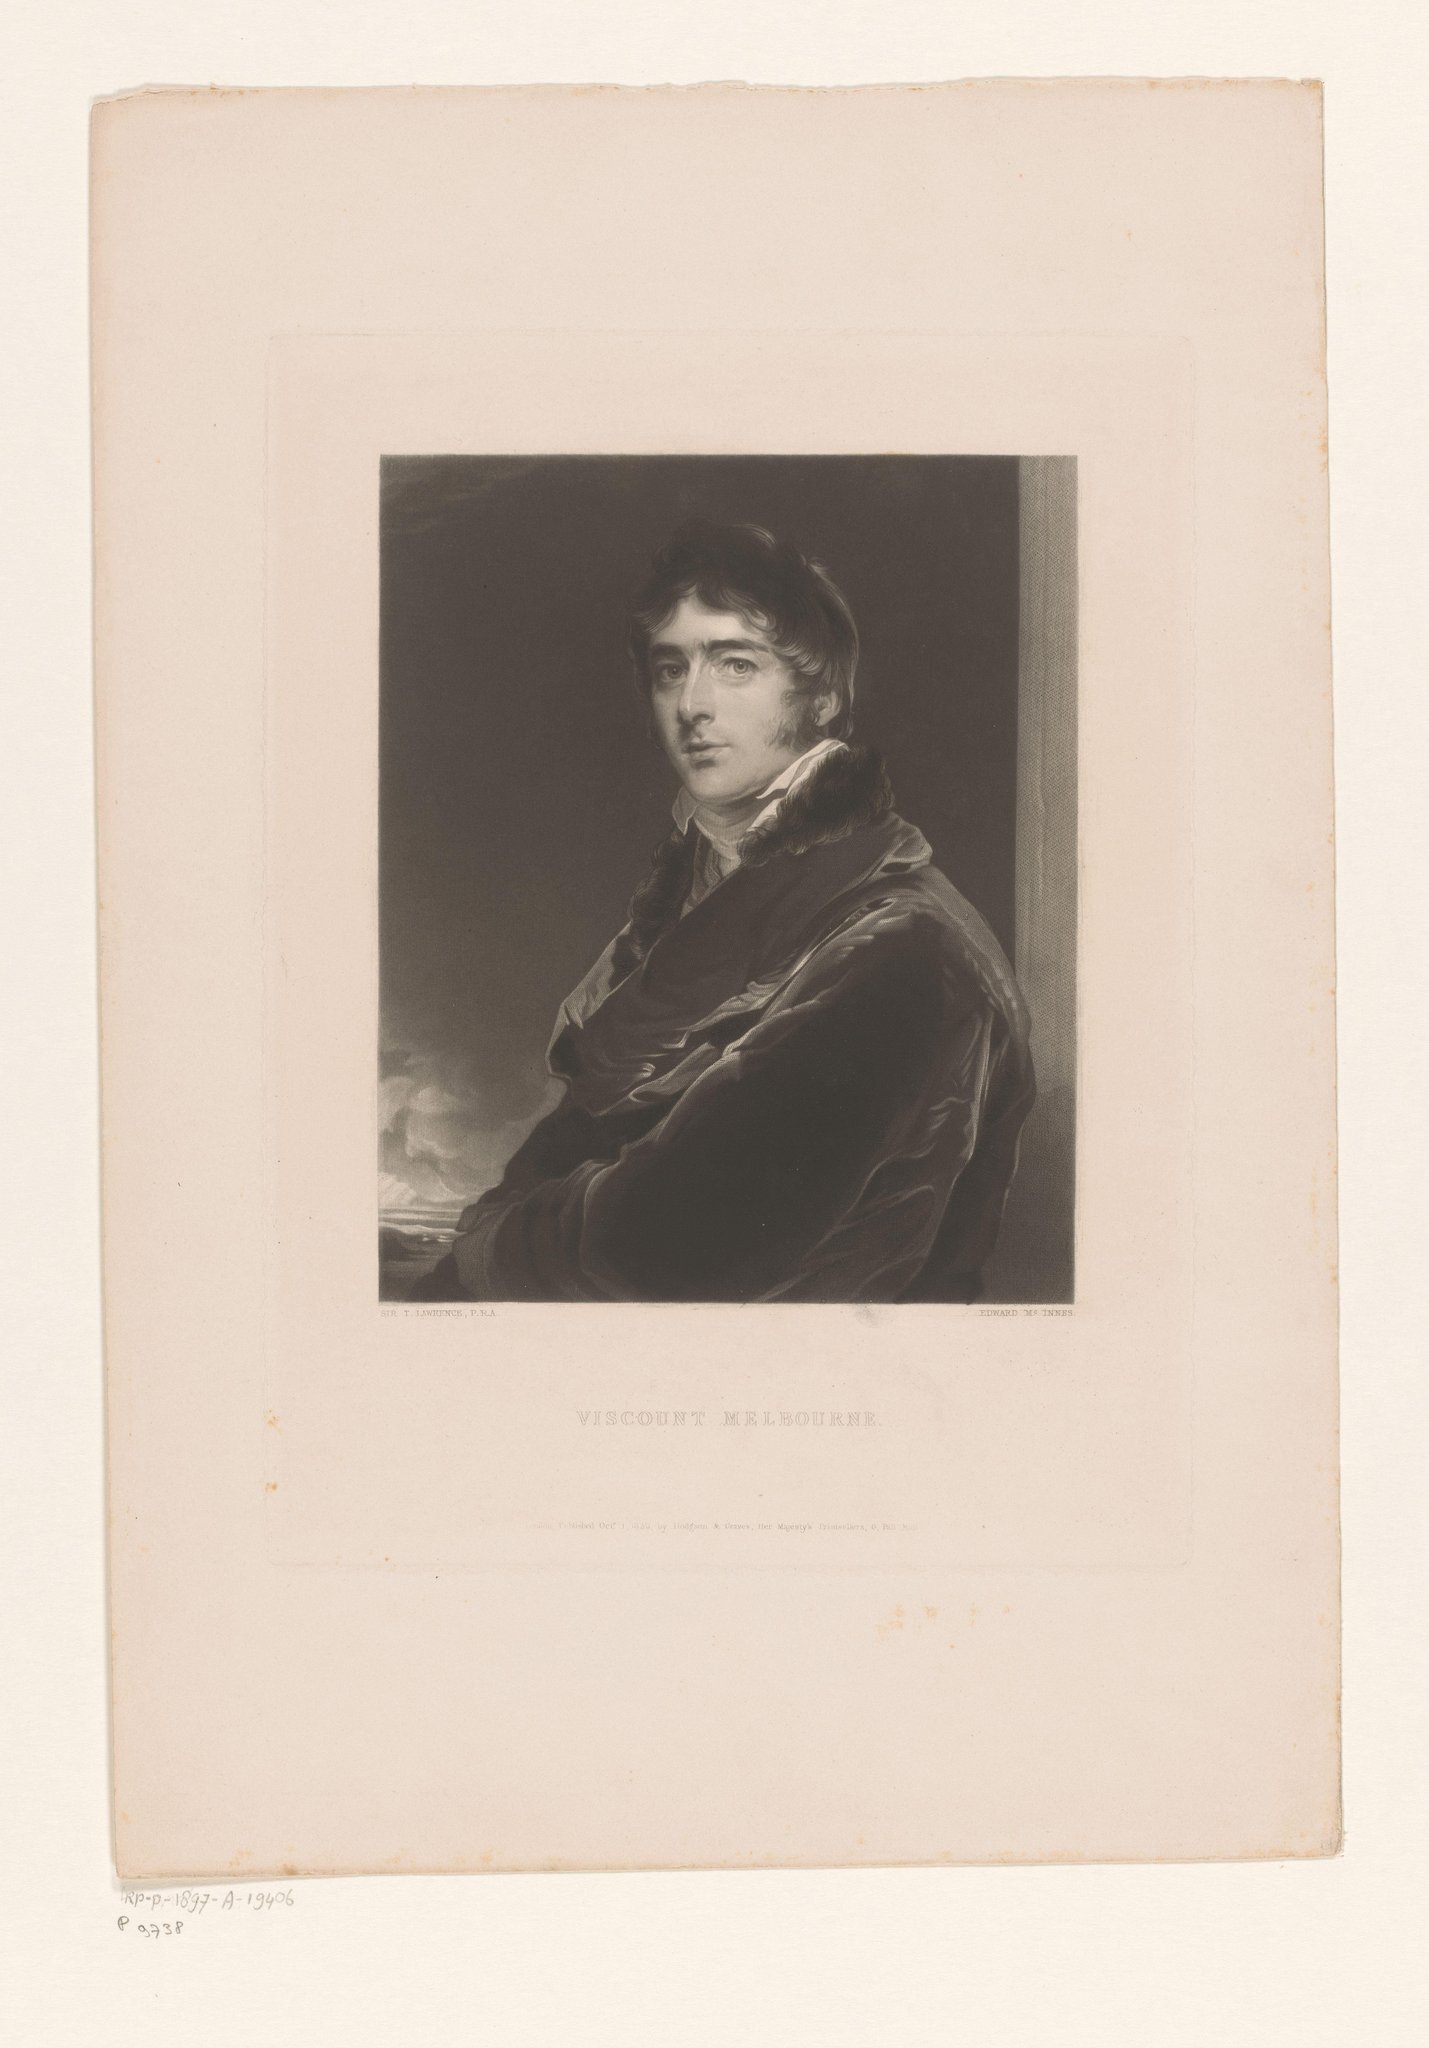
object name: print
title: Portret van William Lamb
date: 1859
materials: paper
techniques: mezzotint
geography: london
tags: politician, minister ~ government, historical persons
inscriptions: collector's mark: Lugt 2228